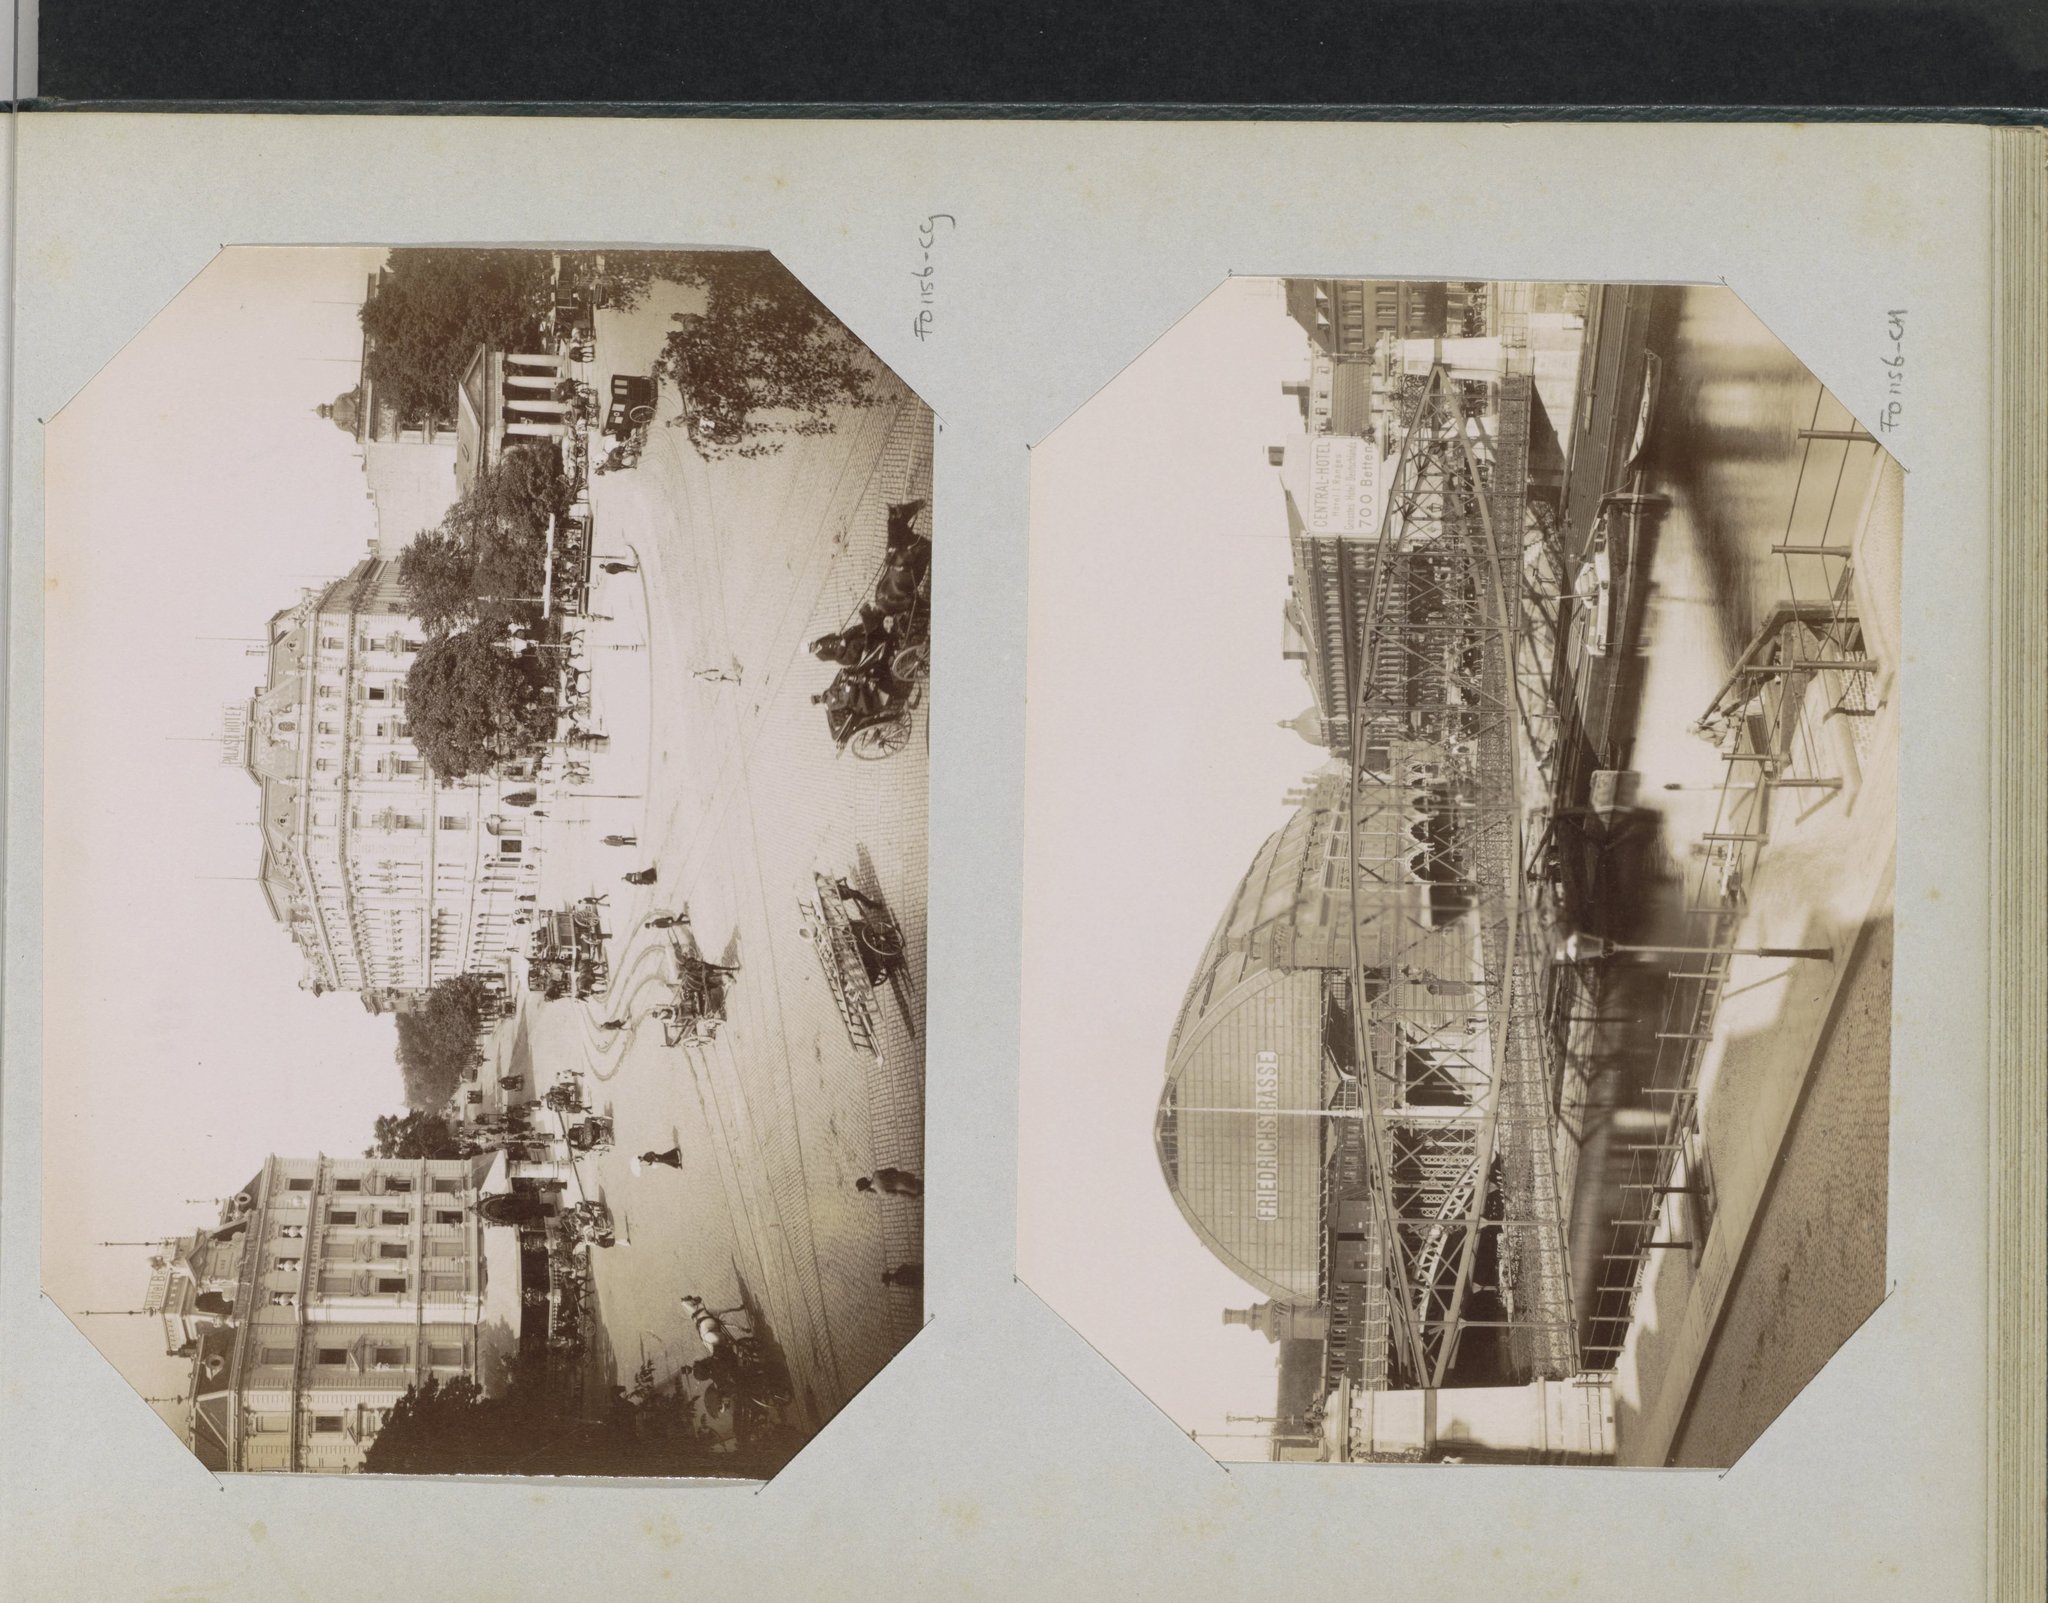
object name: album leaf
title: Gezicht op het station Berlin Friederichstrasse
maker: Anonymous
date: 1886-1896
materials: photographic support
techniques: albumen print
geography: berlin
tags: station; shelter (railway, tramway), berlin